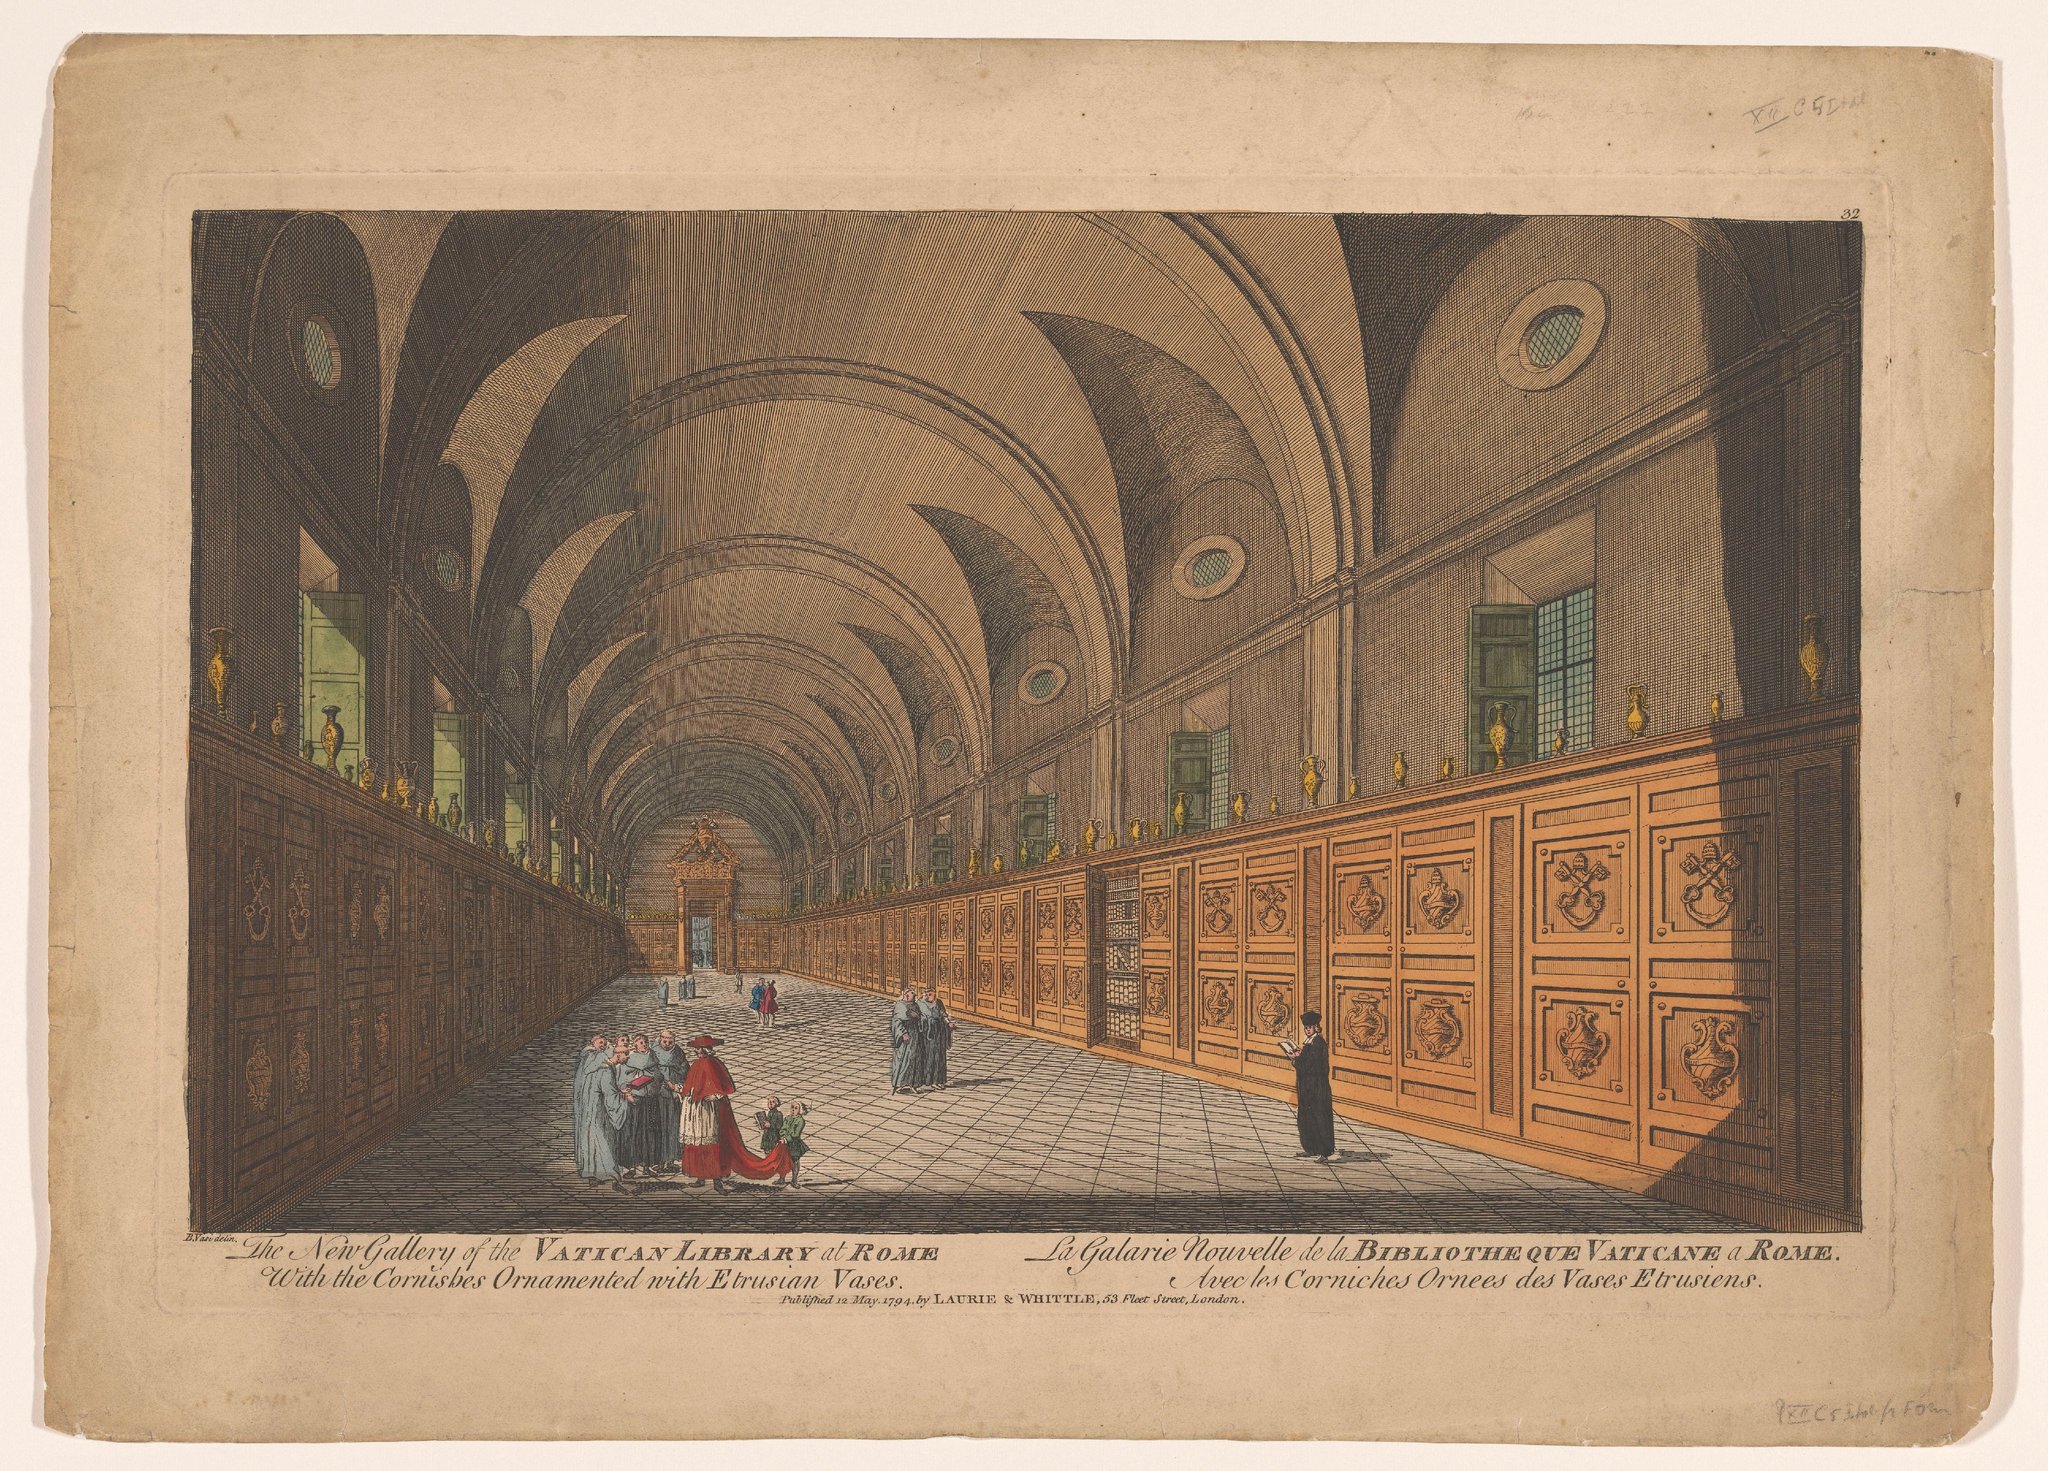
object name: opticaprent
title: The New Gallery of the Vatican Library at Rome / La Galarie Nouvelle de la Bibliotheque Vaticane a Rome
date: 1705-1794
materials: paper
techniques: etching, hand coloring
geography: london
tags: public library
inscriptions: collector's mark: Lugt 4779, collector's mark: Lugt 2228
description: De kasten zijn versierd met pauselijke wapens. Bovenop staan Etruskische vazen. In de galerij lopen geestelijken. Op de voorgrond houden twee kinderen de sleep van het gewaad van een kardinaal vast. Rechtsboven genummerd: 32.